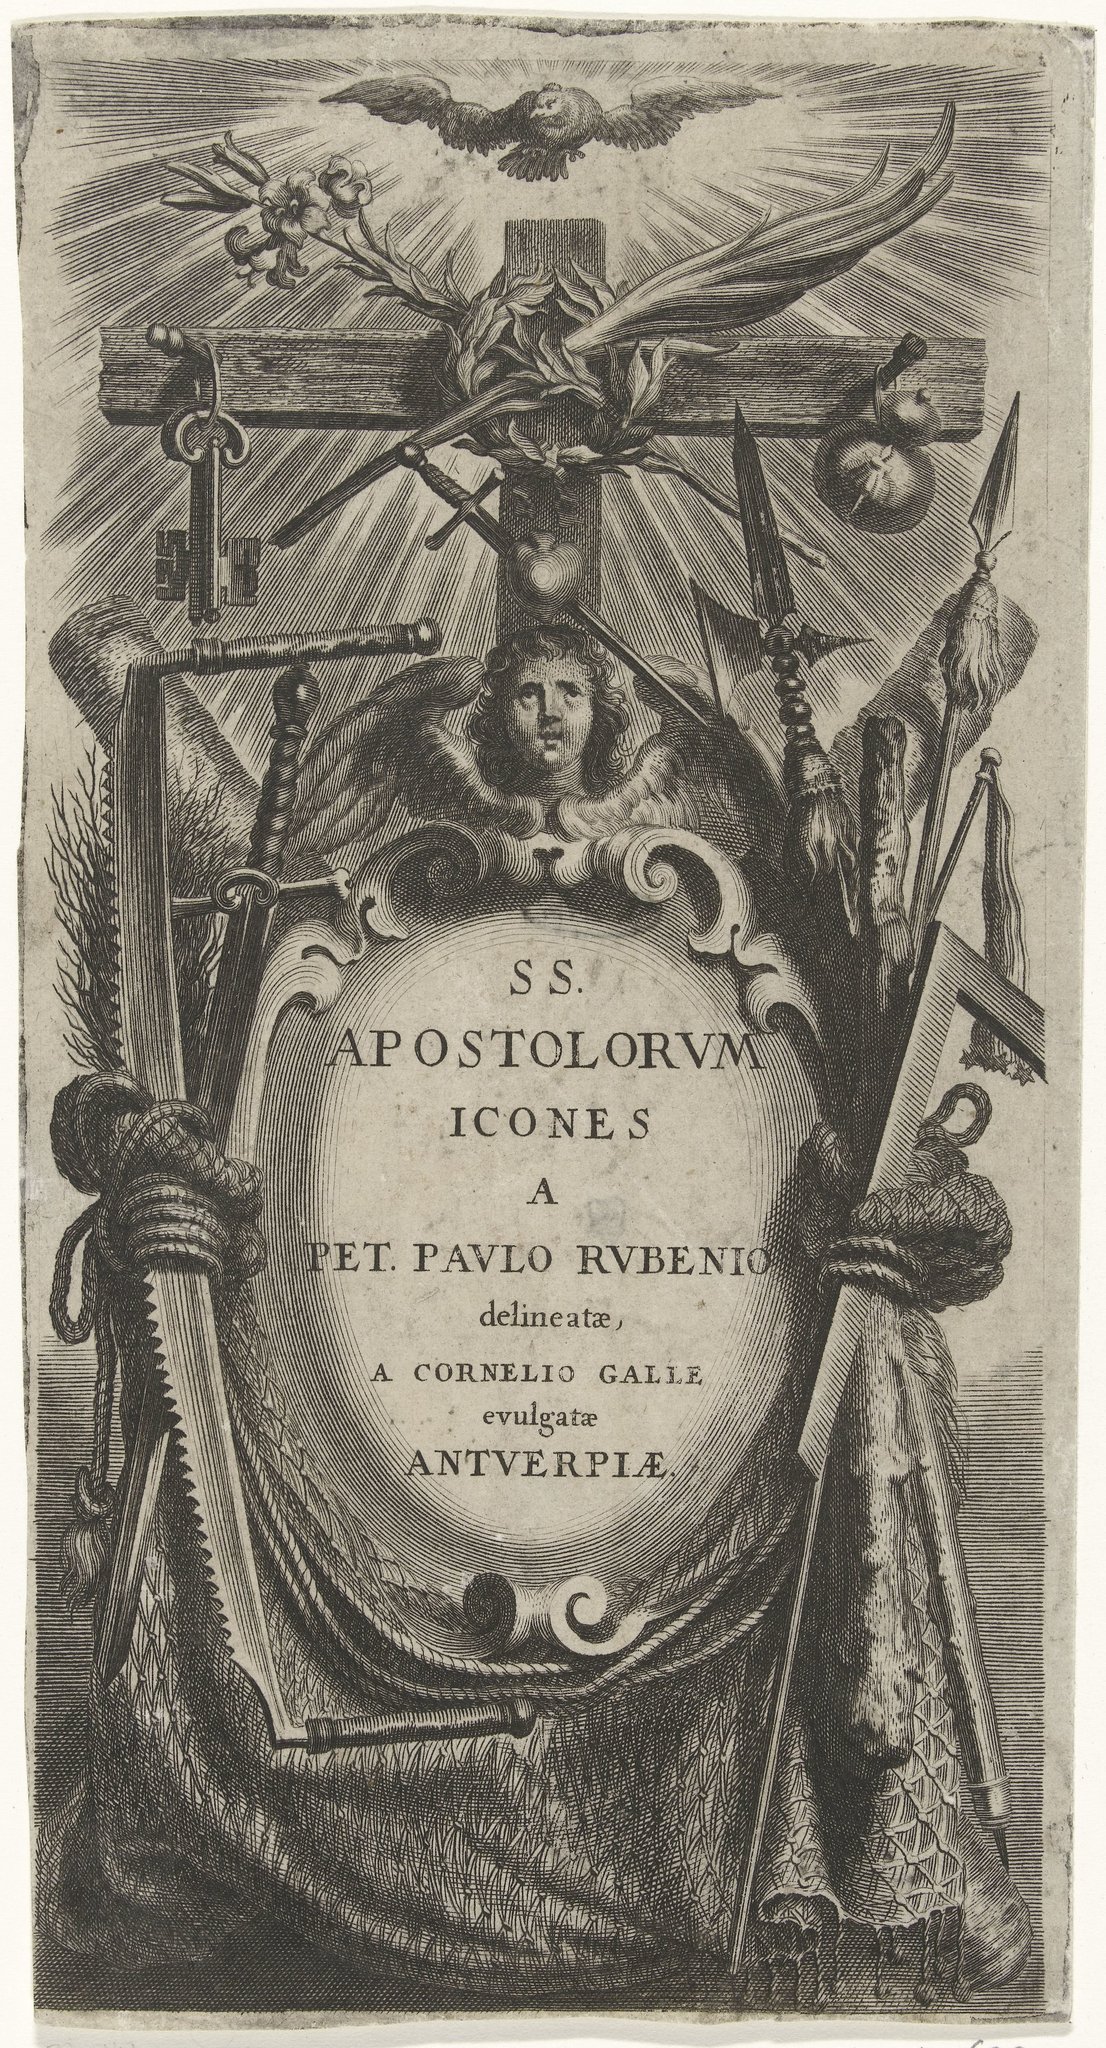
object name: titelprent, frontispice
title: Titelprent voor een serie met afbeeldingen van de apostelen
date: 1586-1650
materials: paper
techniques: engraving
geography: antwerp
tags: symbolic representations of the twelve apostles, e.g.: twelve doves, twelve lambs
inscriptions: collector's mark: Lugt 2760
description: Vignet met de titel van de serie. Eromheen zijn de attributen van de verschillende apostelen geplaatst. Helemaal boven de Heilige Geest in de gedaante van een duif.